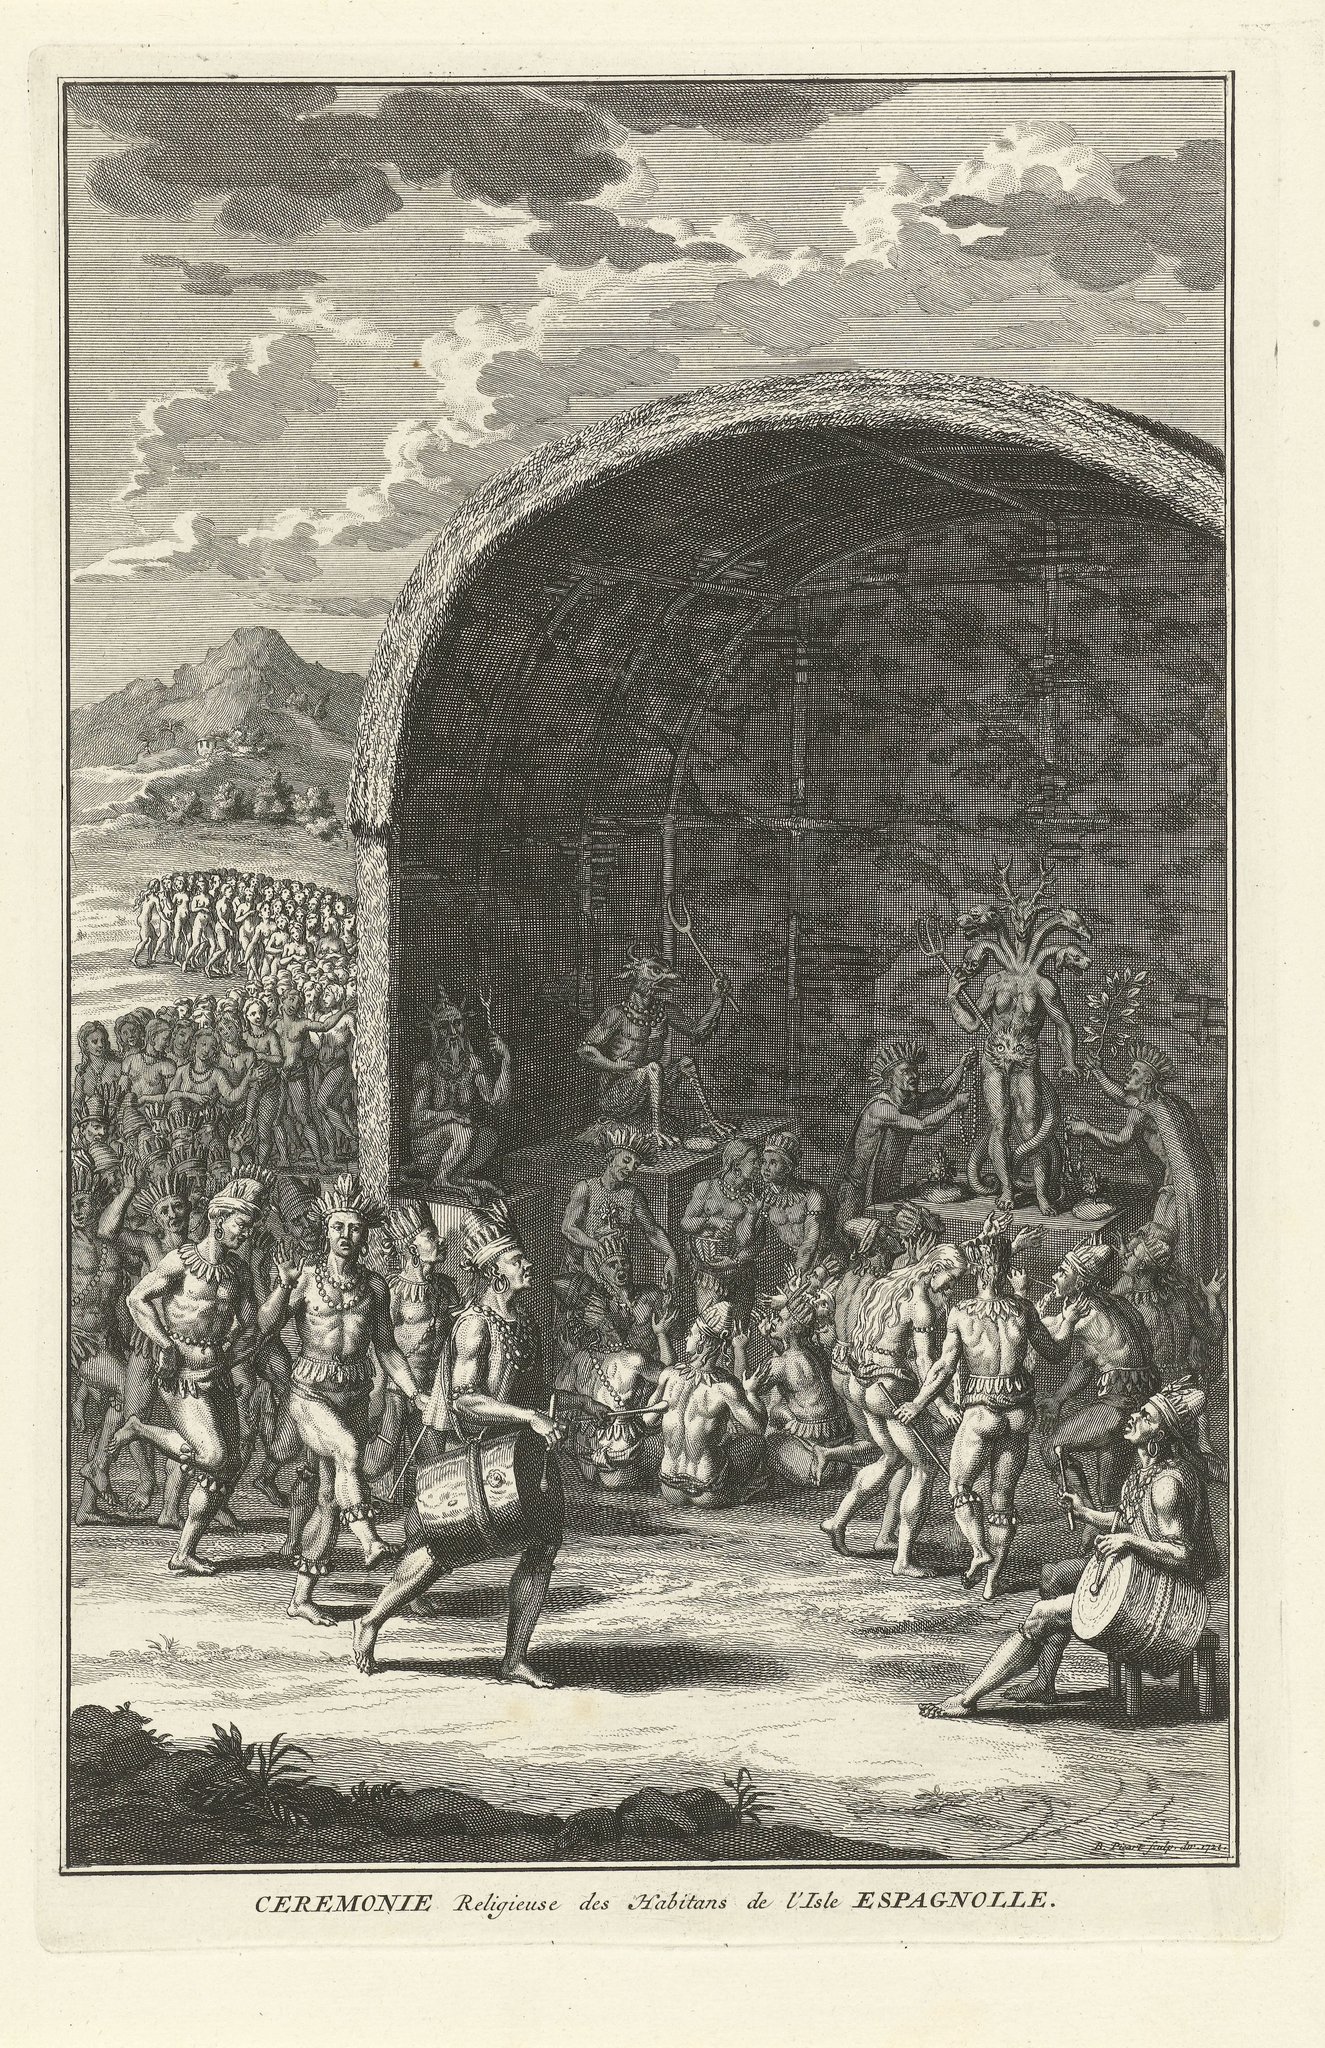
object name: print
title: Voorstelling van een religieuze ceremonie op het eiland Hispaniola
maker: bernard picart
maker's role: draughtsman, print maker, publisher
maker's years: 1673-1733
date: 1721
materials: paper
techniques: engraving, etching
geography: amsterdam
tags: ritual practices ~ american indian religions, temple, shrine ~ american indian religions, representations ~ gods, demi-gods, heroes, etc. (american indian religions), native peoples of the americas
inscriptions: collector's mark: Lugt 2228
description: Prent ook gebruikt in: Picart, Bernard. Naaukeurige beschryving der uitwendige godtsdienst-plichten, kerk-zeden en gewoontens van alle volkeren der waereldt. [Vertaald in het Nederlands door] Moubach, Abraham. Den Haag, Amsterdam, Rotterdam: Rutgert Alberts, Hermannus Uytwerf, Jan Daniel Beman, Isaac van der Kloot, 1727-1738. Prent ook gebruikt in: Cérémonies et coutumes religieuses de tous les peuples du monde: représentées par des figures, deel III. Amsterdam: Jean Frédéric Bernard, 1723-1743.